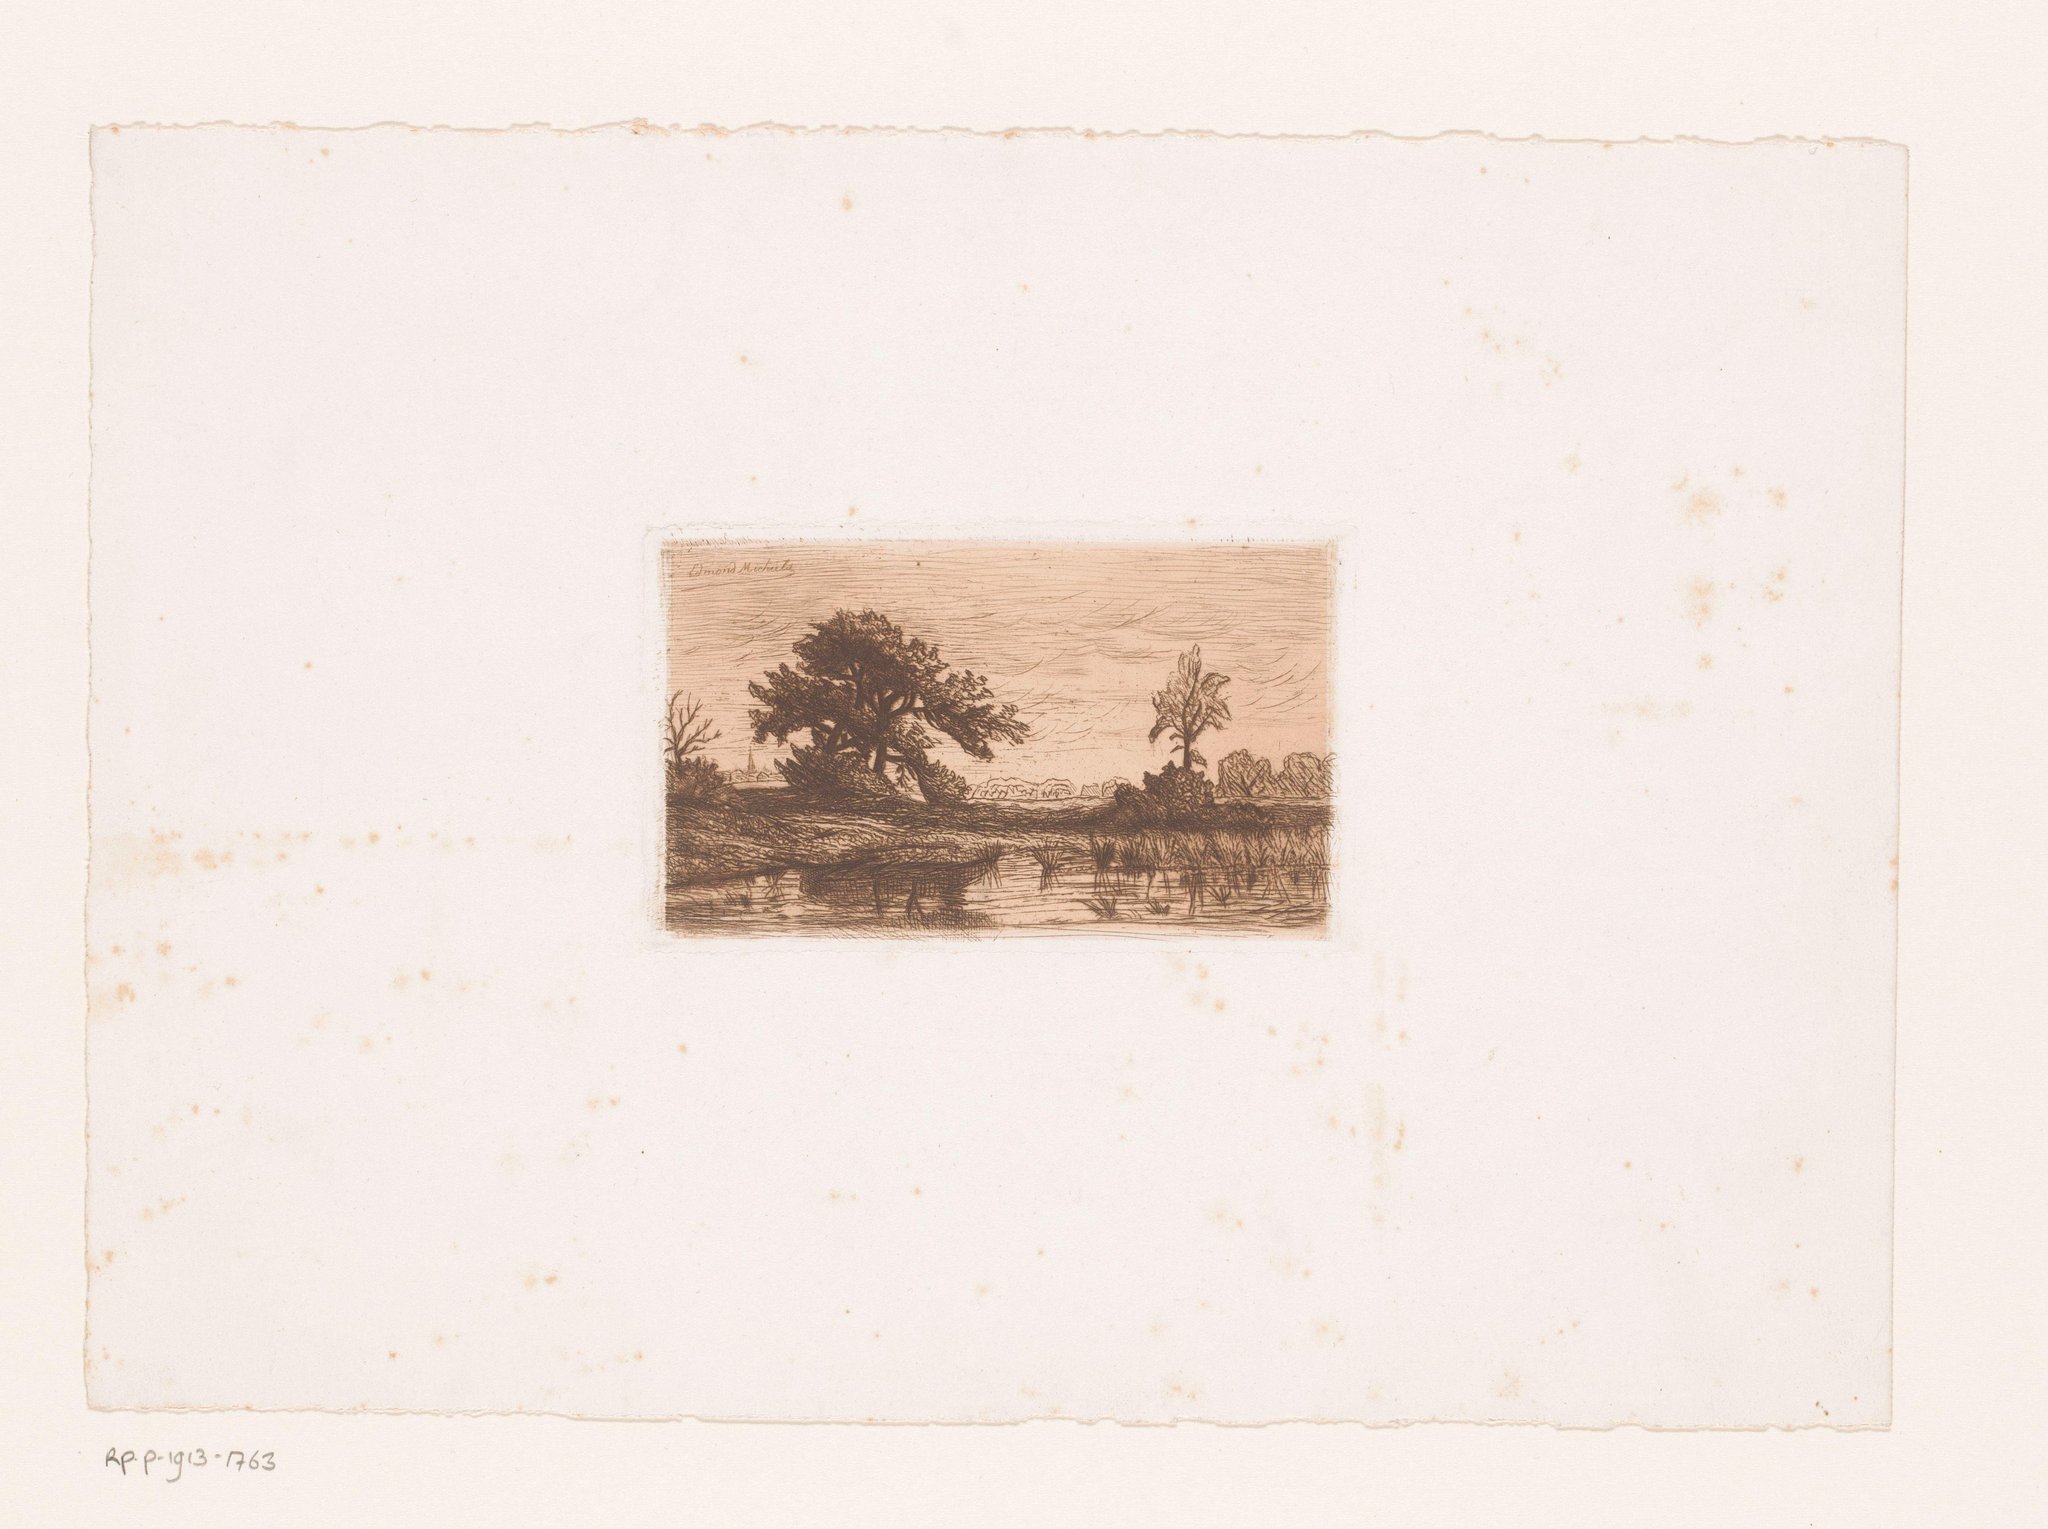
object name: print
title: Landschap met waterplas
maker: edmond michiels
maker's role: print maker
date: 1850-1913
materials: paper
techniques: etching, intaglio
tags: landscapes with waters, waterscapes, seascapes (in the temperate zone) (+ landscape with figures, staffage)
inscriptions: collector's mark: Lugt 2228